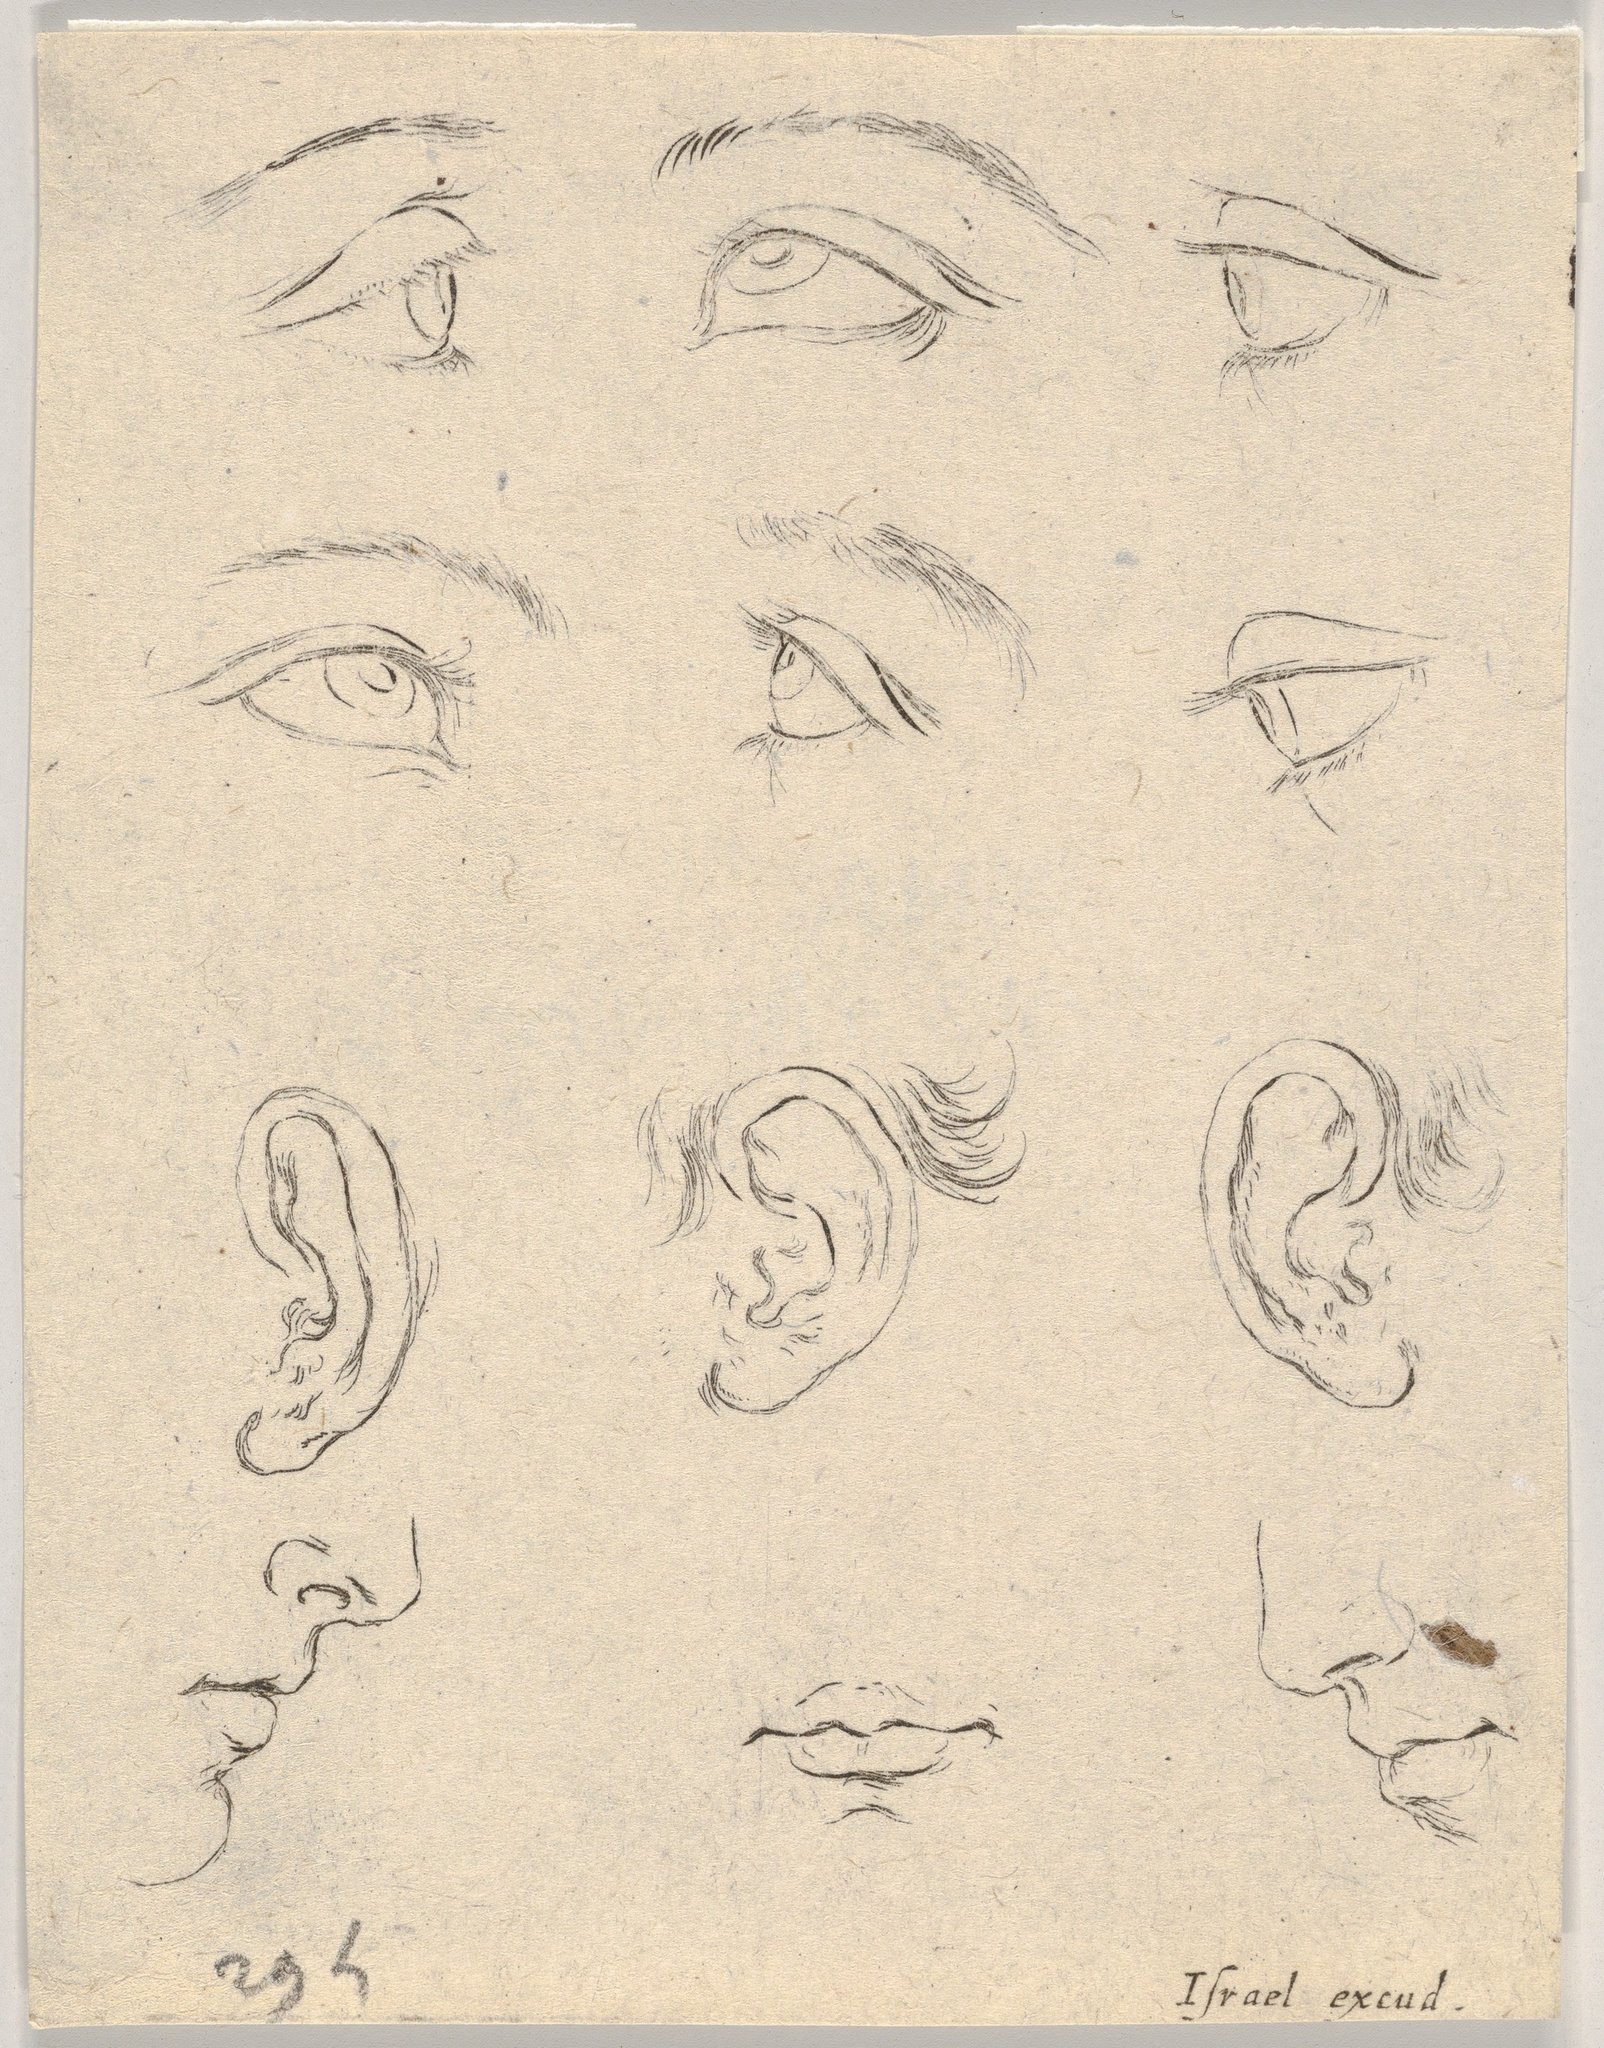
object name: print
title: Plate 3: Six eyes, three ears, two profiles, and a mouth, from "The Book for Learning to Draw" (Livre pour apprendre à dessiner)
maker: stefano della bella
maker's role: artist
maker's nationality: italian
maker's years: 1610-1664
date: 1649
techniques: etching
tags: eyes,mouths,profiles